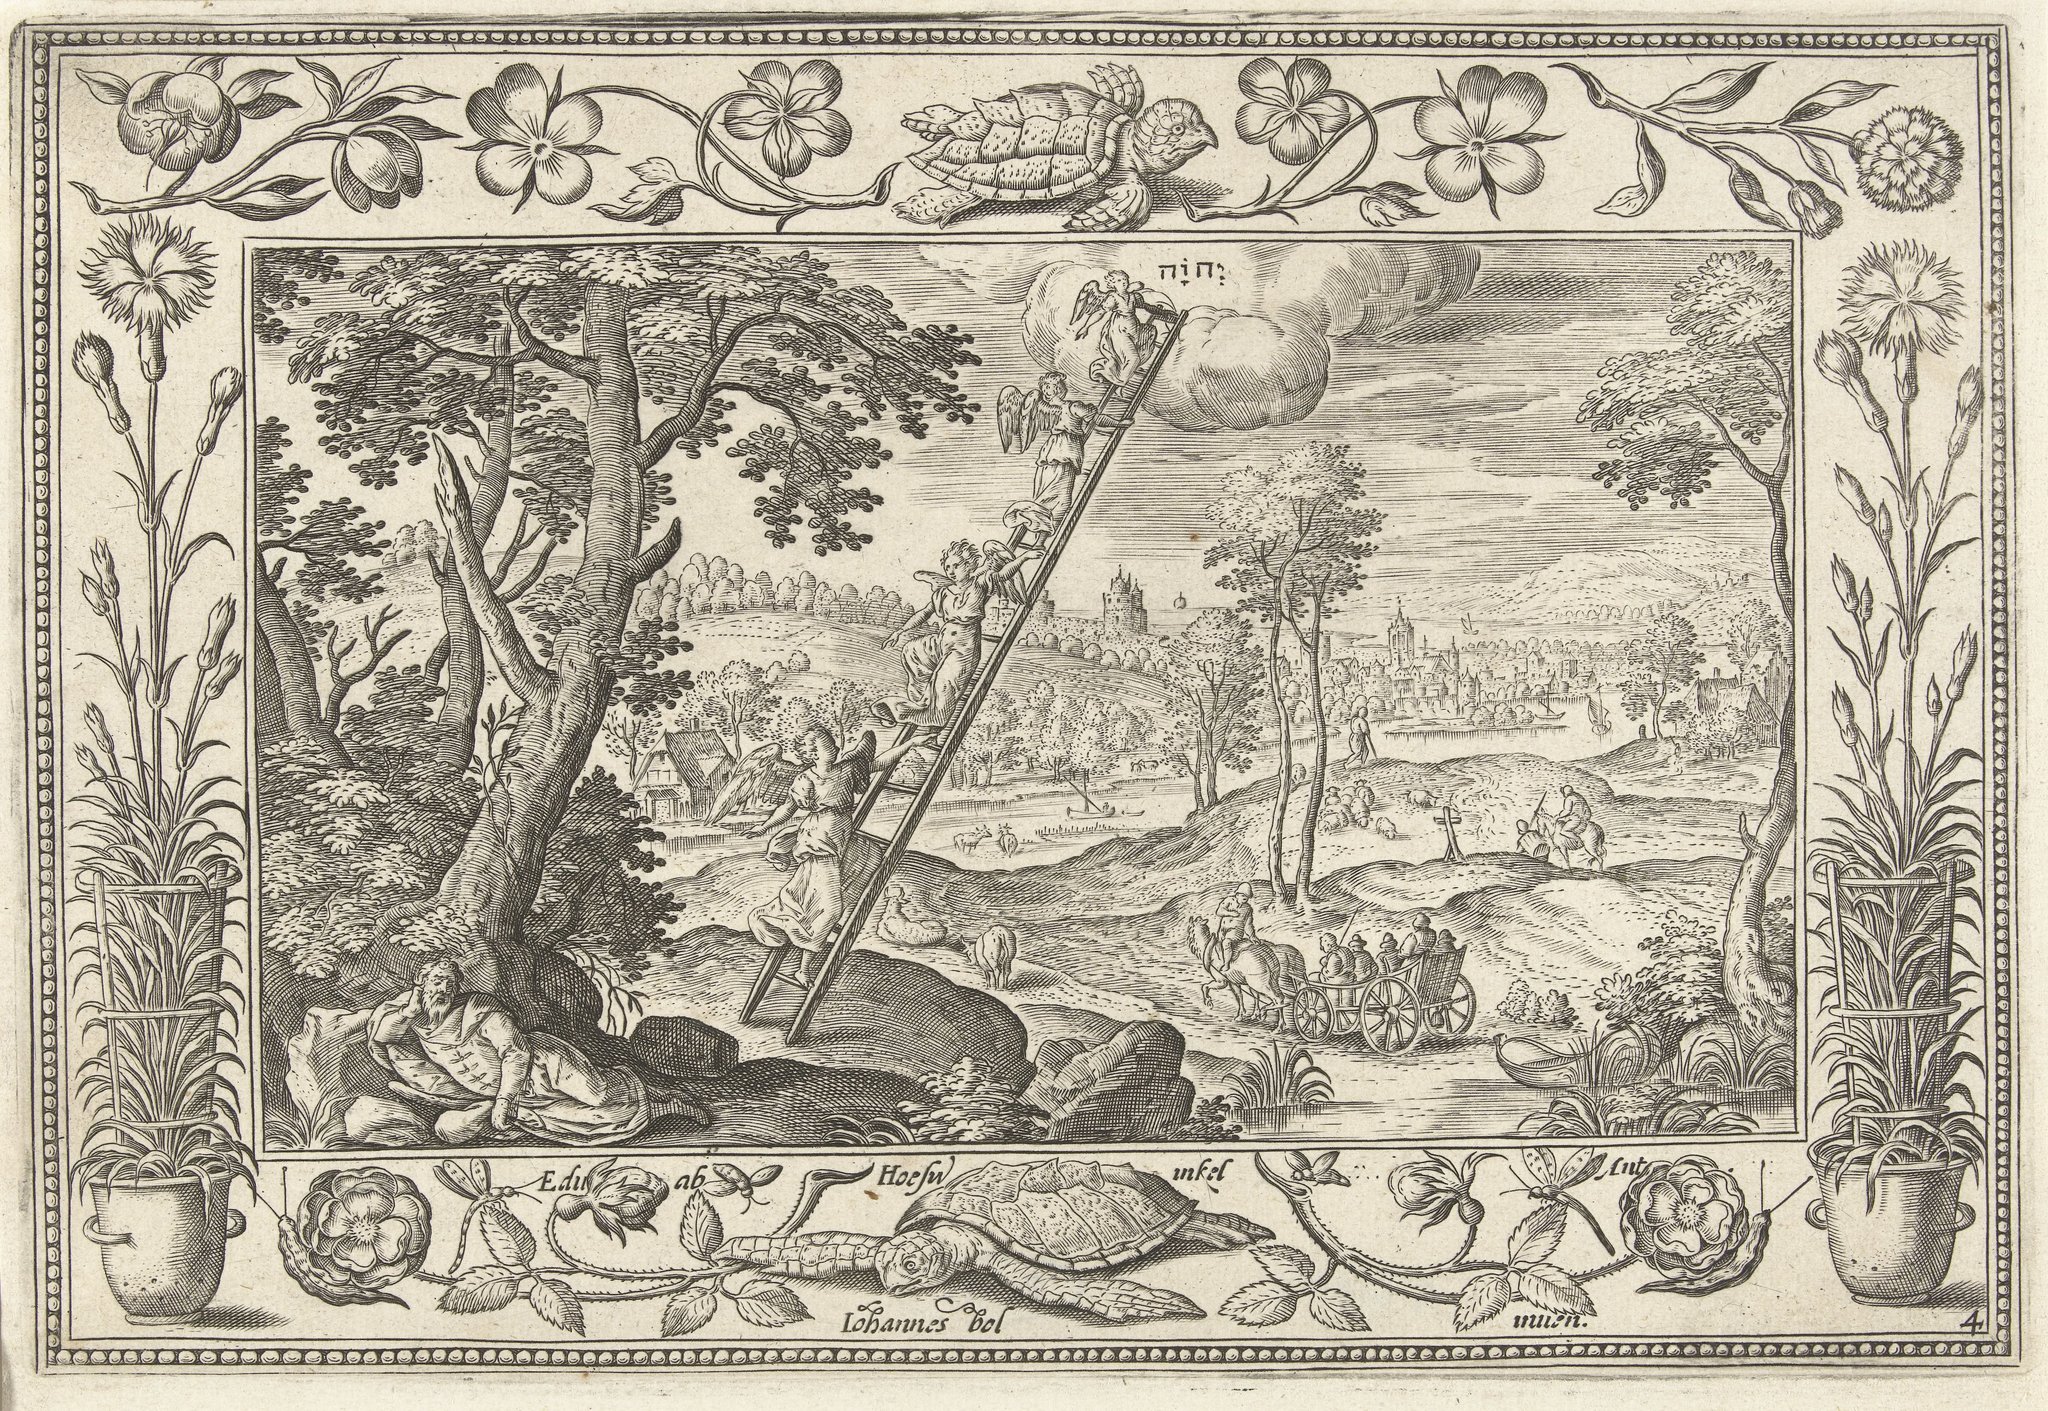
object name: print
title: Landschappen met Bijbelse, mythologische scènes en jachttaferelen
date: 1582-1586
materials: paper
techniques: engraving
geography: antwerp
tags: river, tetragram (in roman or hebrew script) ~ symbol of god the father, the dream of jacob: while sleeping on the ground with a stone for pillow jacob sees a ladder reaching from earth to heaven with angels going up and down; usually with god at the top of the ladder, tortoises, turtles (+ ornamental variants of animals), flowers ~ ornament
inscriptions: collector's mark: Lugt 2228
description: Landschap met een rivier. Op de voorgrond links de slapende Jakob. Hij droomt dat engelen vanuit de hemel via een ladder omhoog en omlaag klimmen. Boven in de wolken het tetragram. De prent heeft een ornamentlijst met bloemen en schildpadden. Hij maakt deel uit van een vierentwintigdelige serie van landschappen met Bijbelse, mythologische scènes en jachttaferelen.